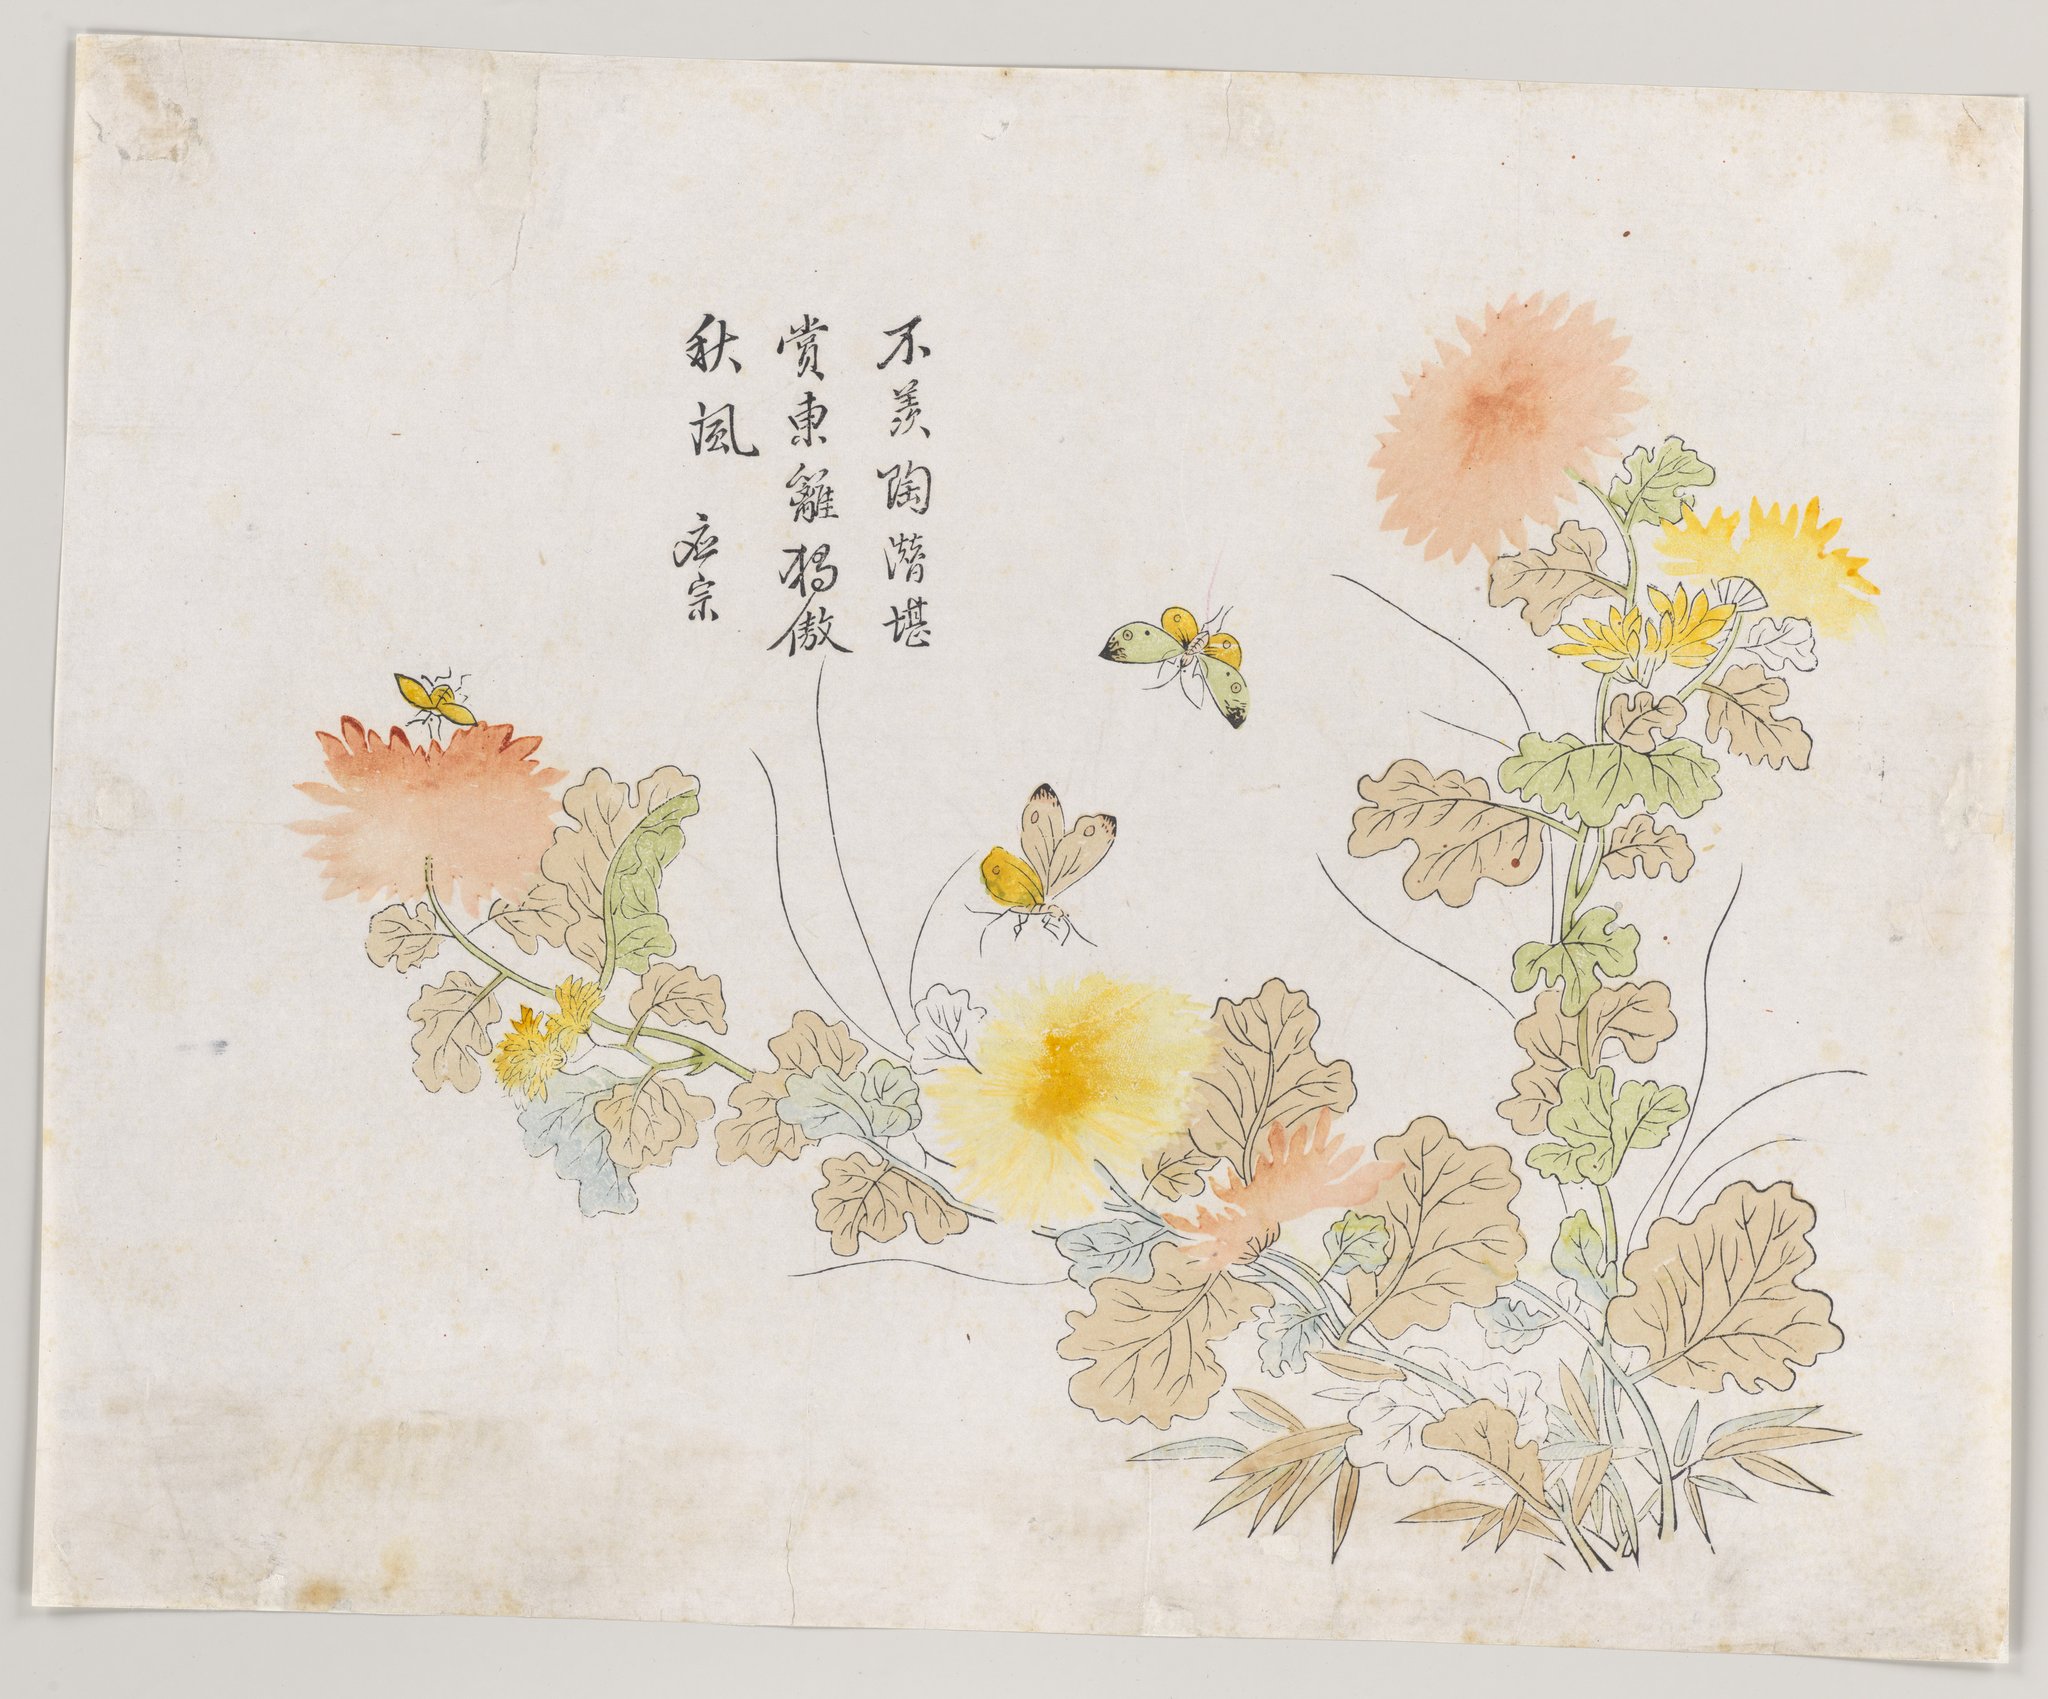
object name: print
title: Butterflies and Bee on Chrysanthemum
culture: chinese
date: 1701-1800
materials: ink, paper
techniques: polychrome, woodblock print